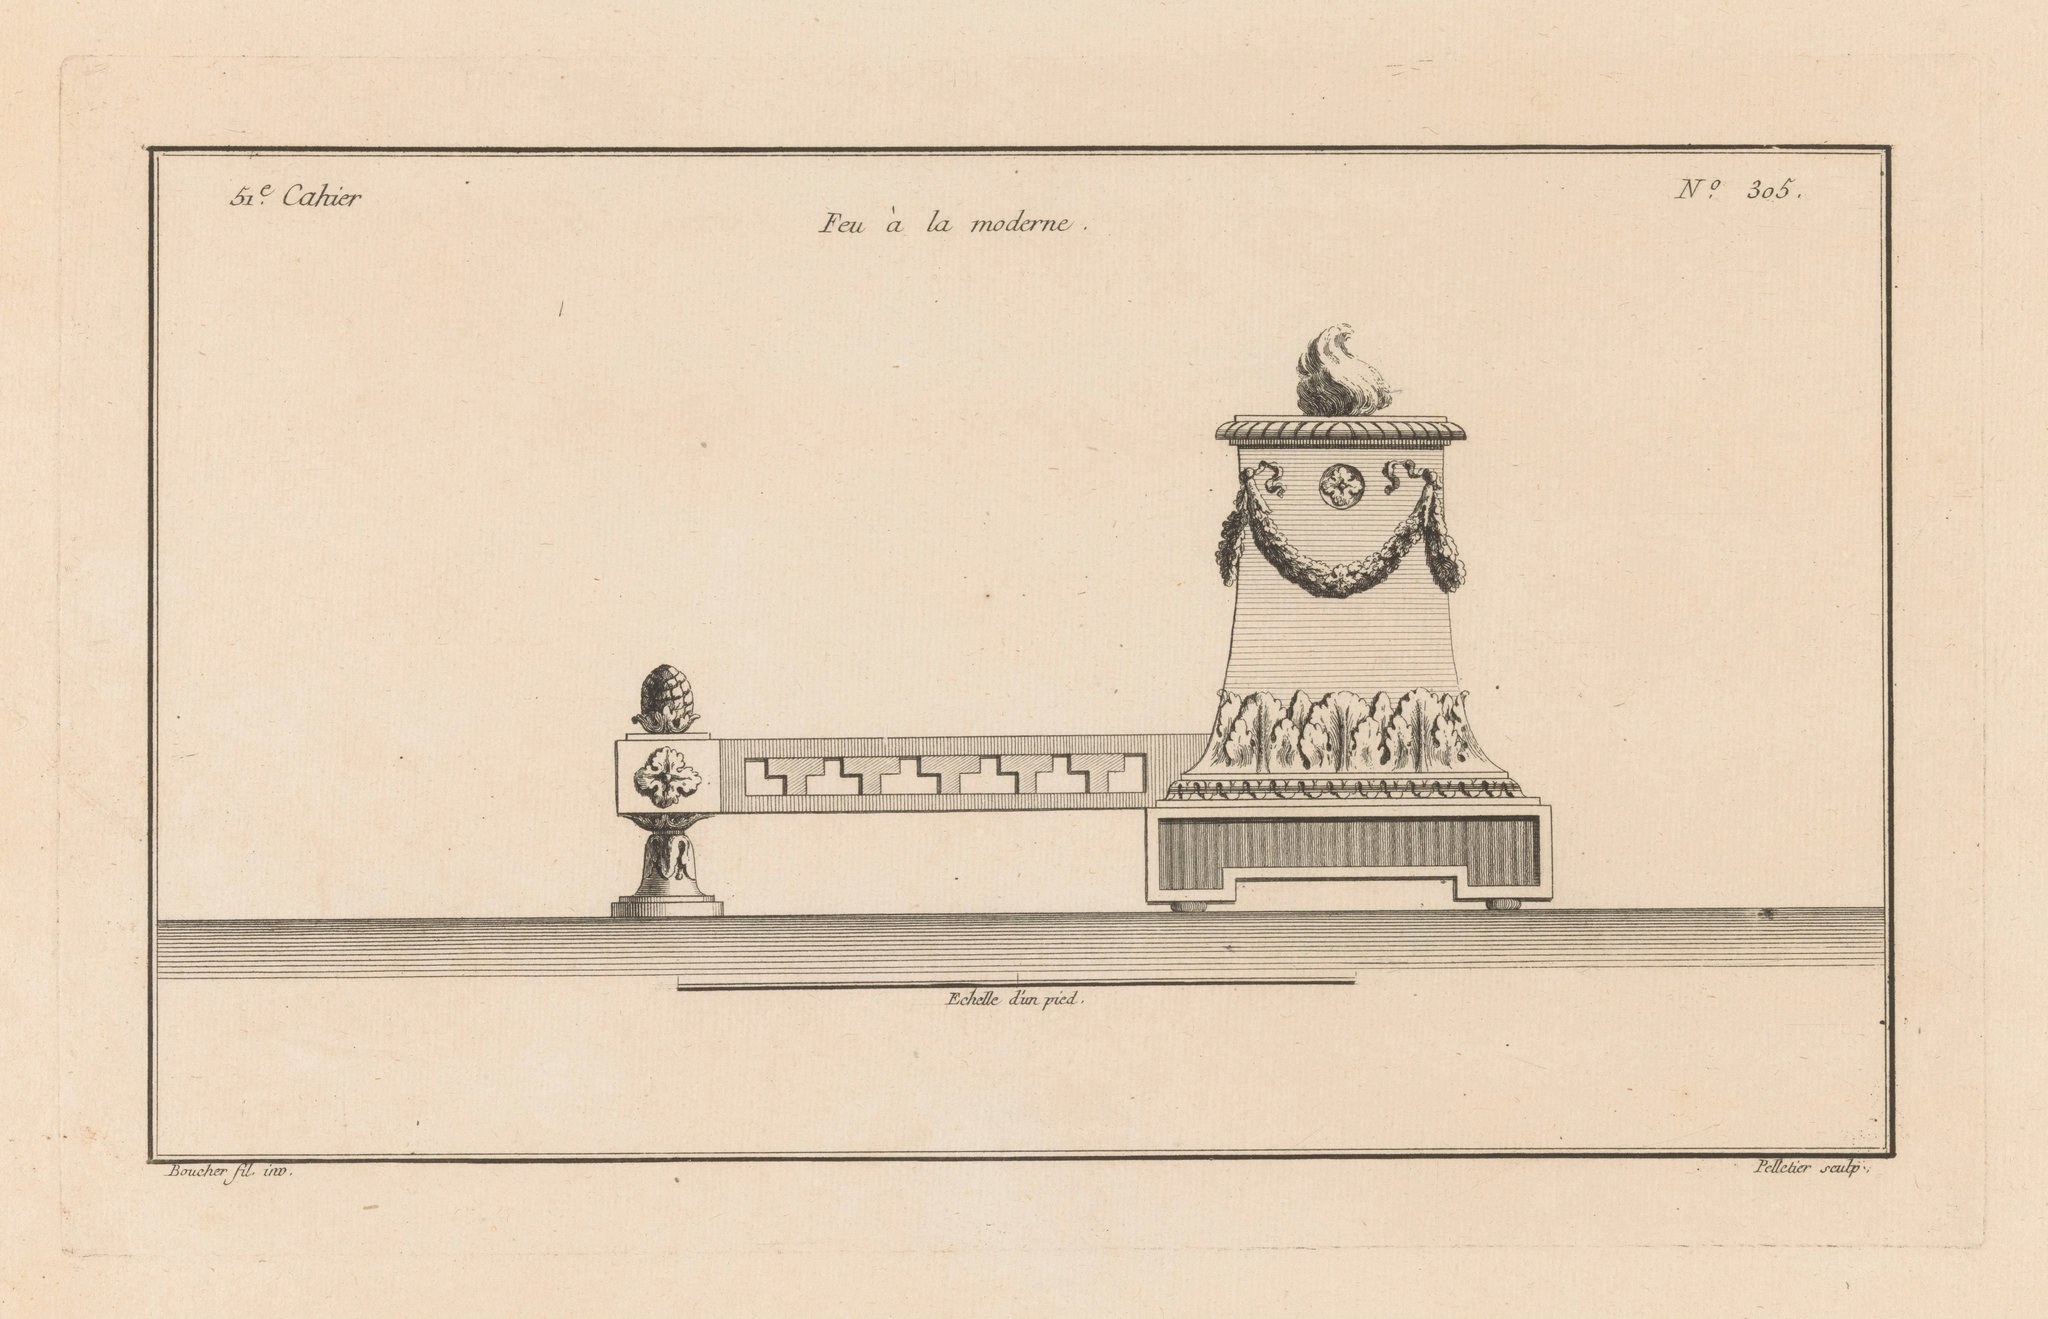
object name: ornament print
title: Feu à la moderne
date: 1772-1779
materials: paper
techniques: engraving, etching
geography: paris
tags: andiron, fire-dog, fruits: pineapple, ornament ~ festoon, garland, flame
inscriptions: collector's mark: Lugt 2760, collector's mark: Lugt 2228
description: Een geornamenteerde vuurbok met een dennenappel, een guirlande en vuur. Prentnummer 305.